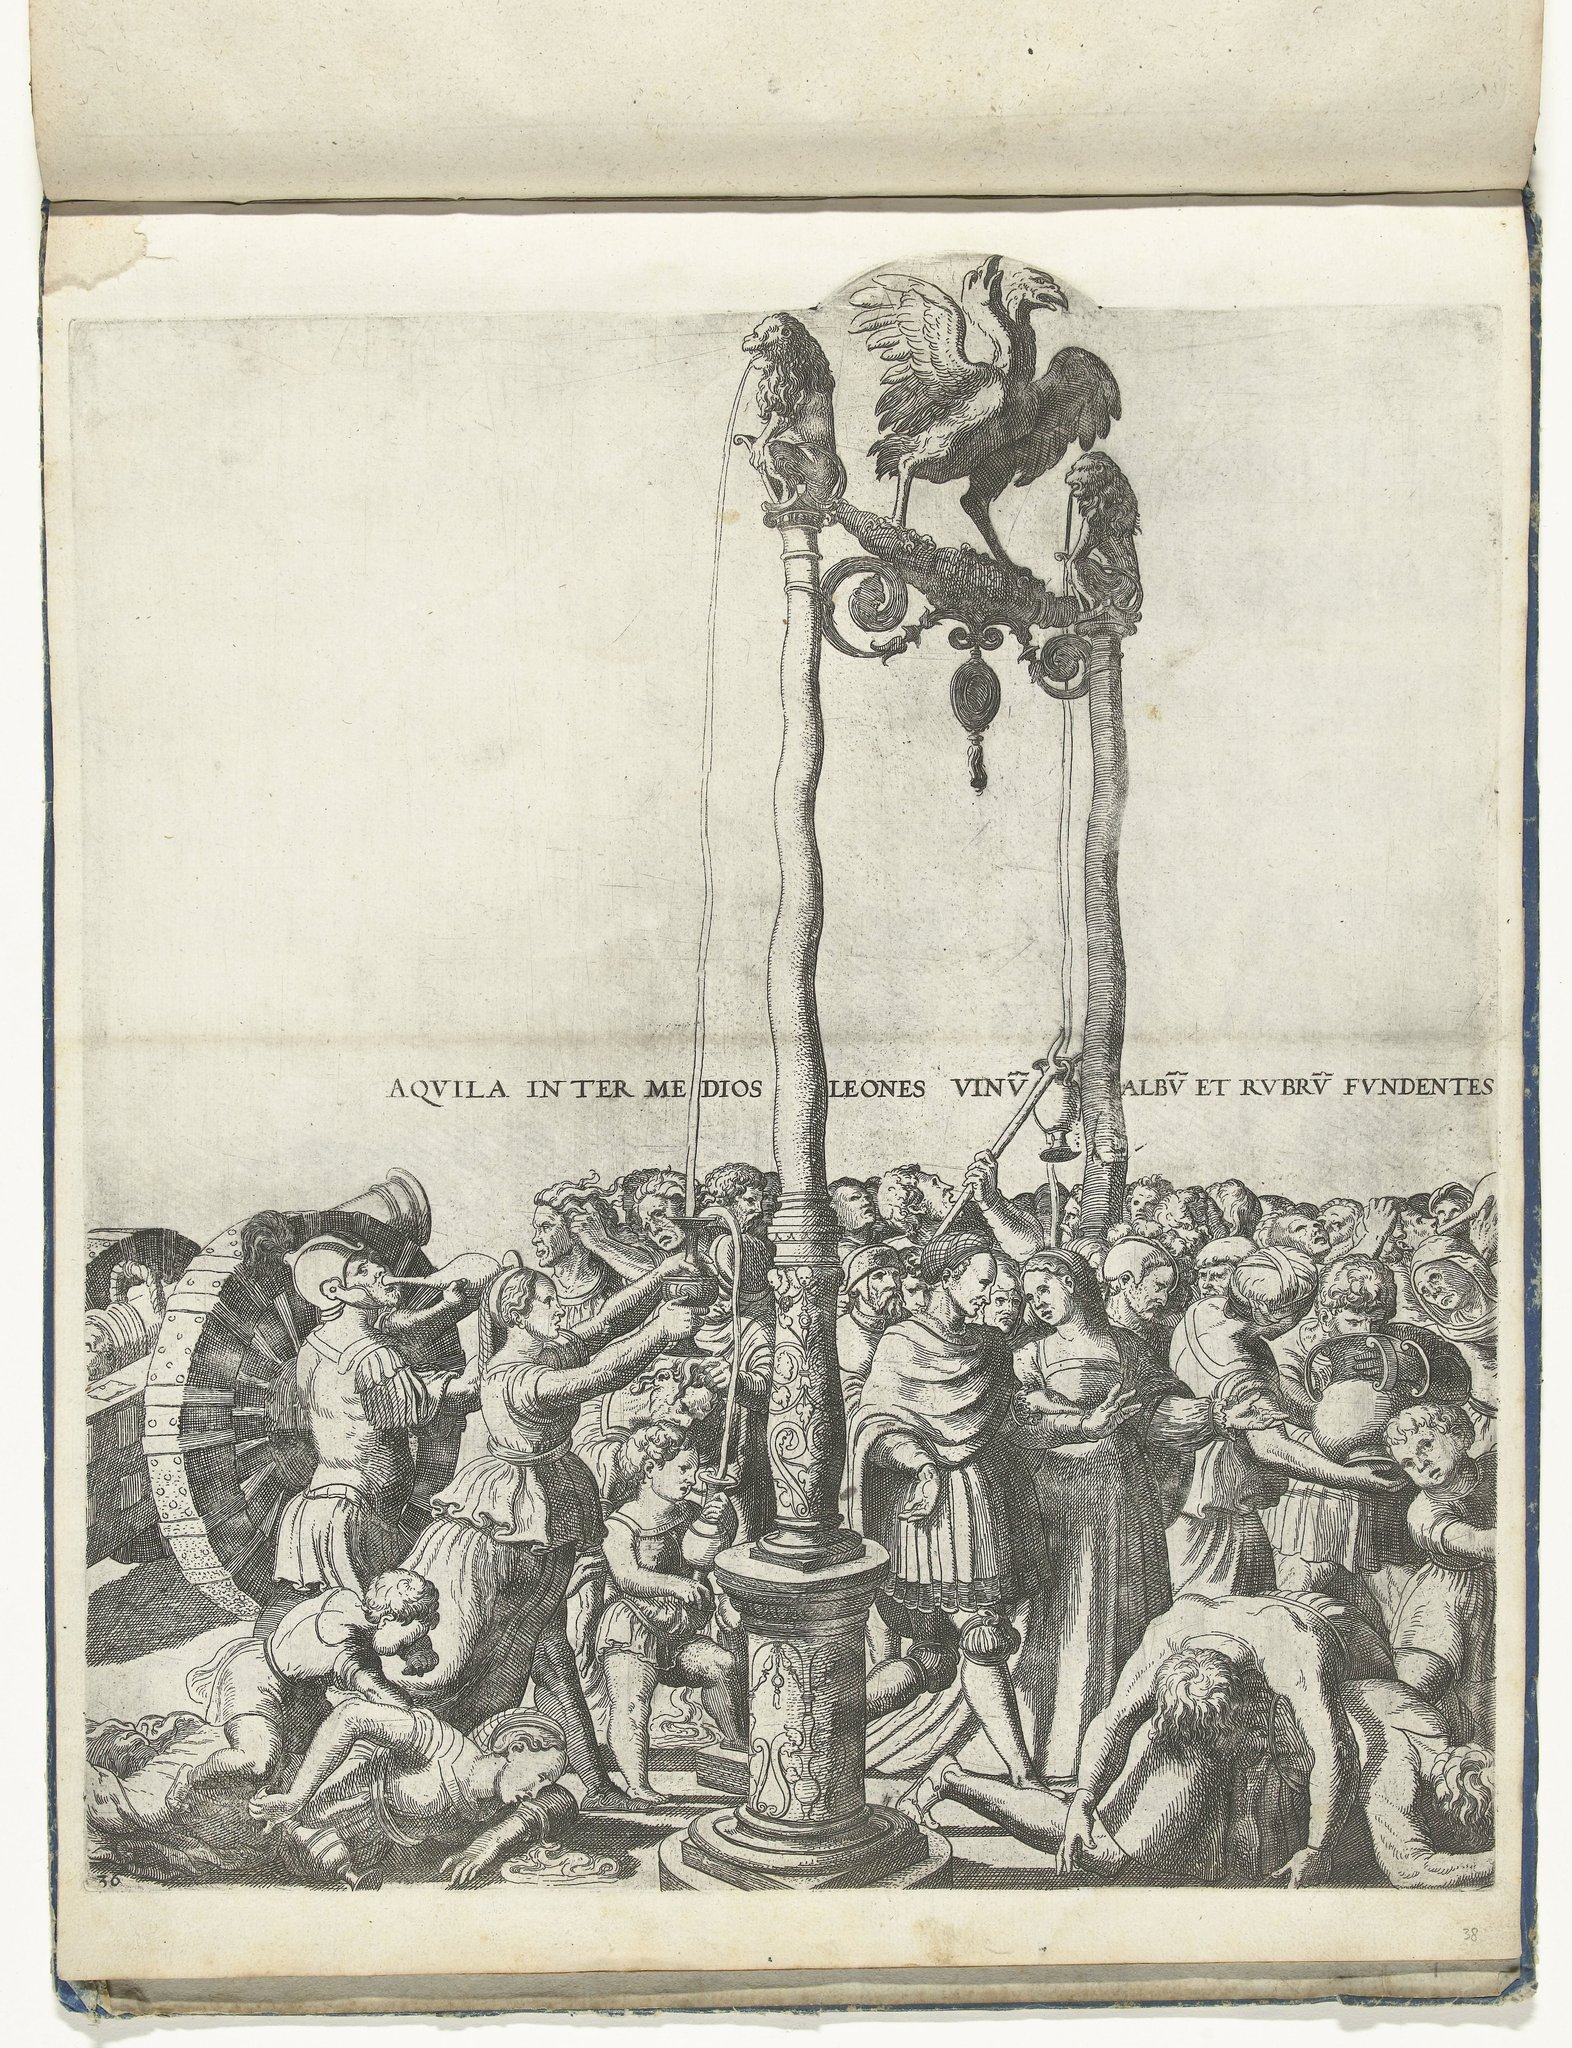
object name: propagandaprent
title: Optocht van Karel V met de paus te Bologna na zijn kroning to keizer, 1530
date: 1530-1536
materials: paper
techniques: engraving, etching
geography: the hague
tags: ghent, charles v (holy roman emperor and king of spain), rome, drunkard, festivities (+ parade, pageant, cavalcade ~ festive activities)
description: Prent in het album waarin zijn ingeplakt de 40 platen die achterelkaar samen het fries vormen van de optocht van Karel V met de paus Clemens VII te Bologna na zijn kroning tot keizer, 24 februari 1530.